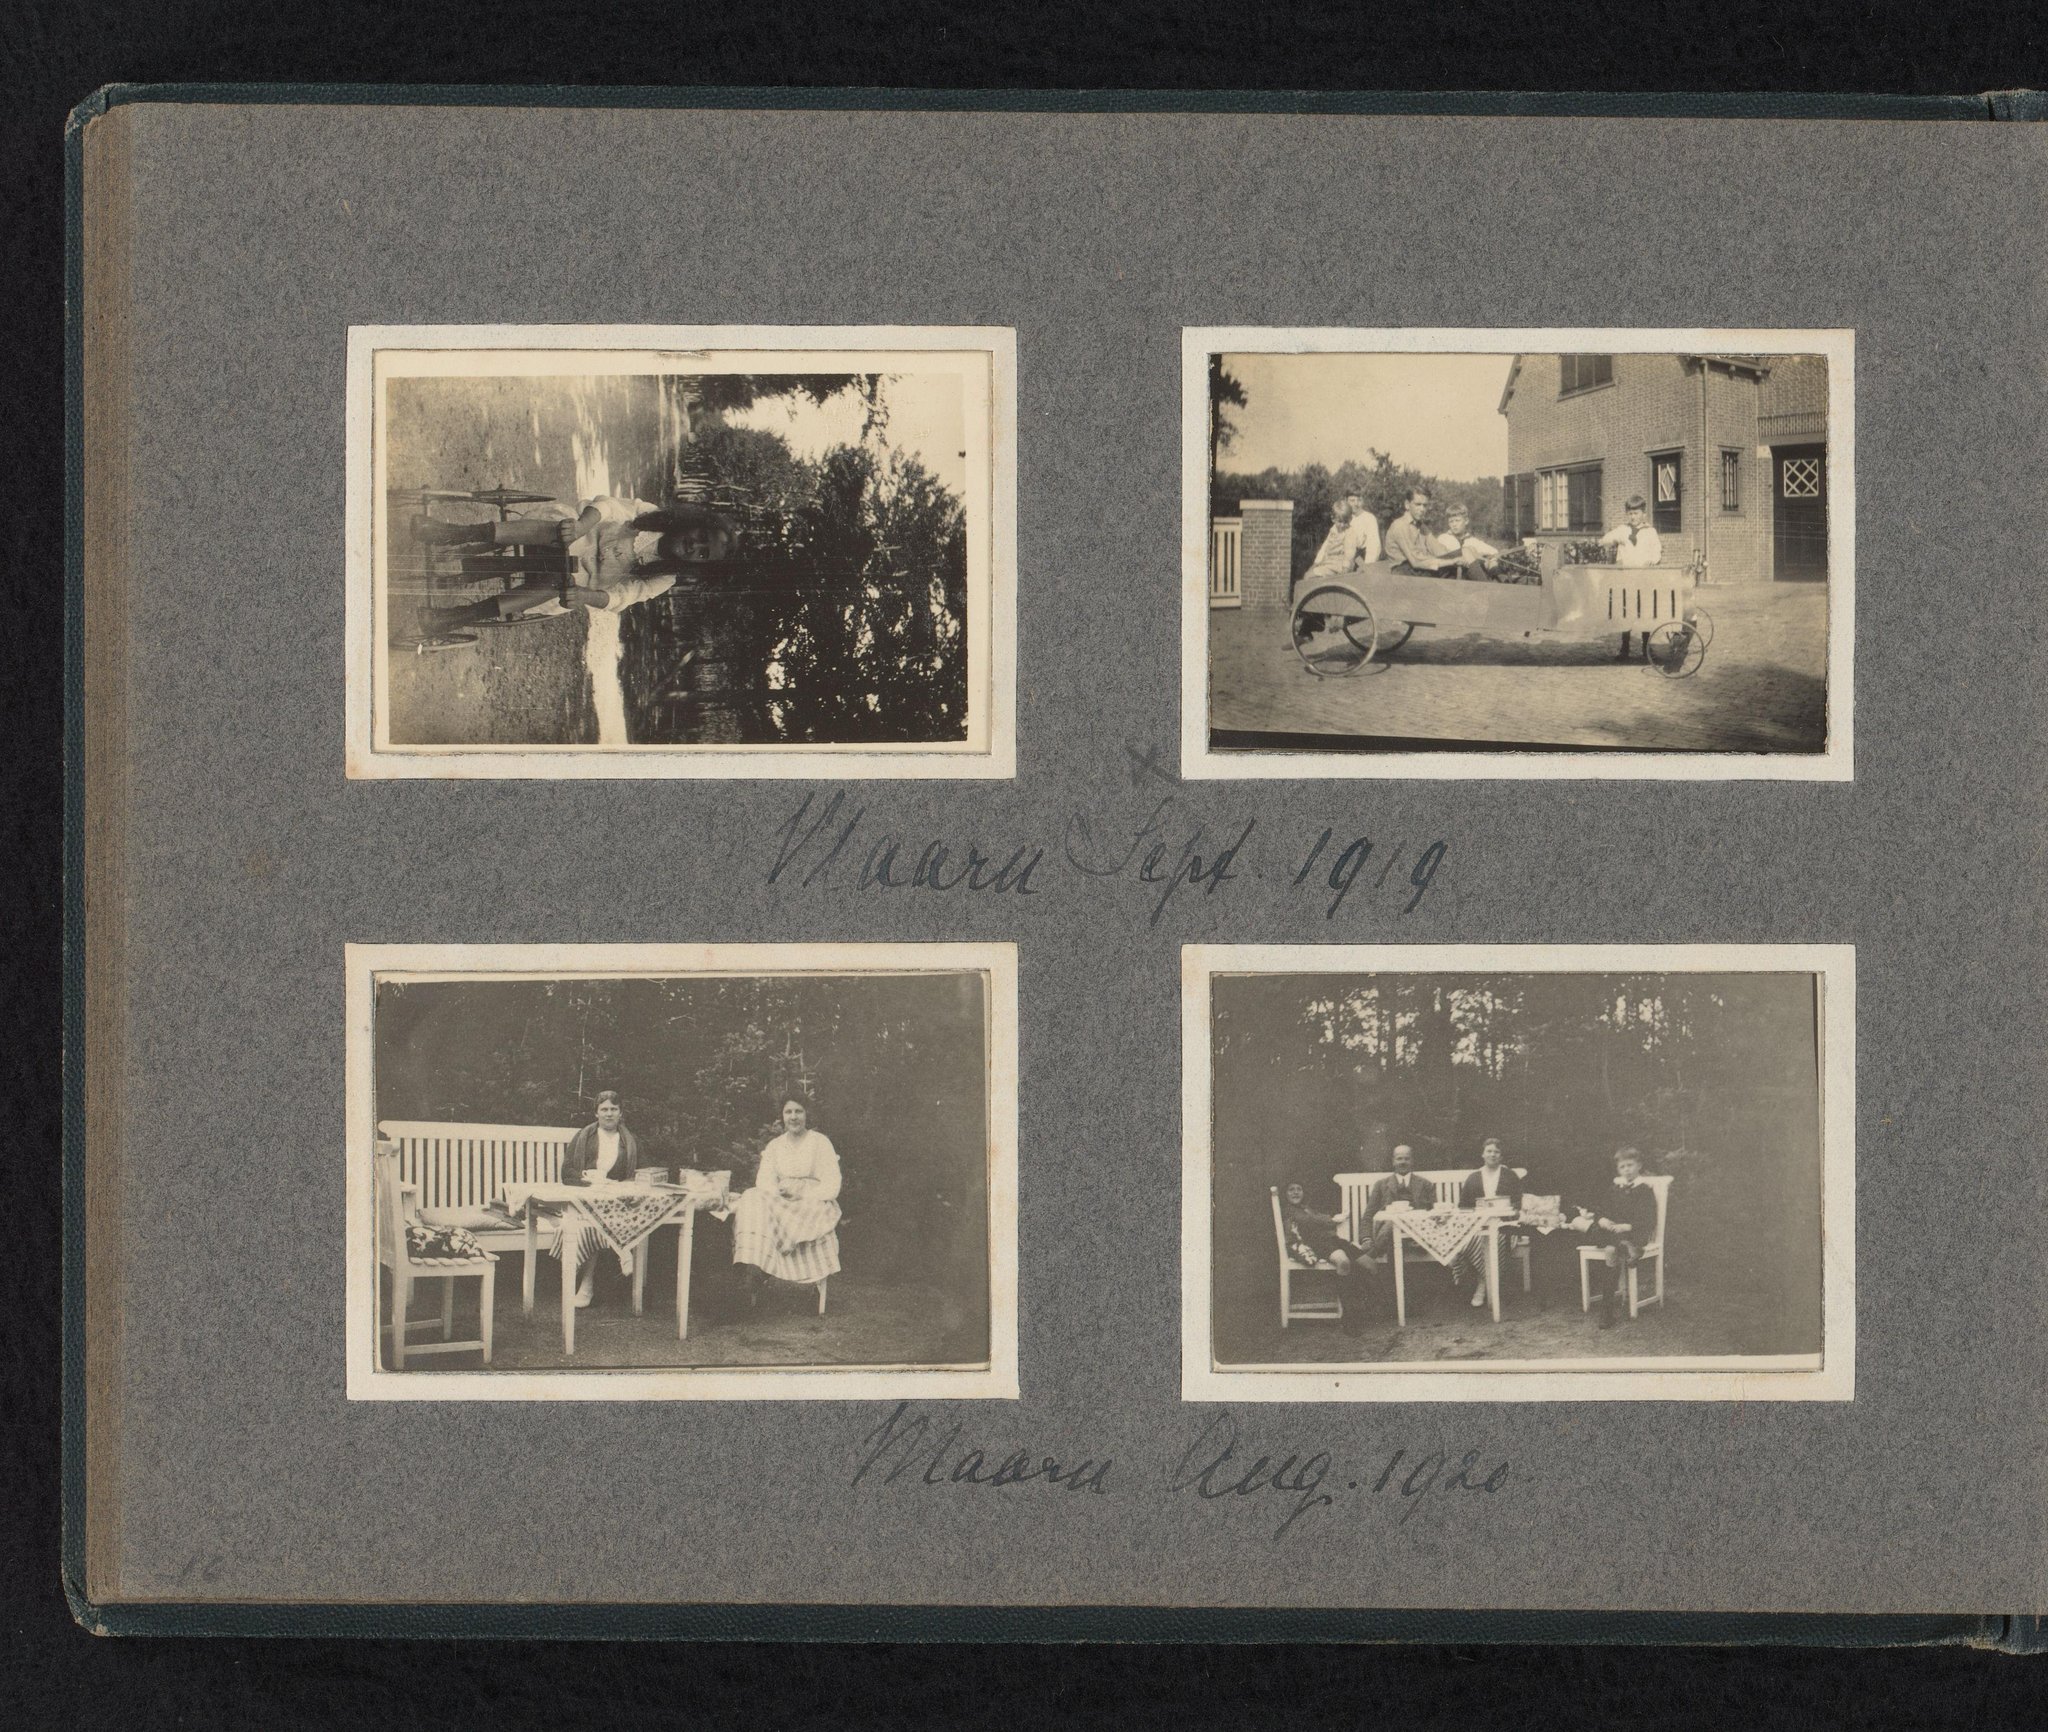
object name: photograph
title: Familie van den berg in Maarn, met Hendrik, Caroline, Carel en Frank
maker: hendrik herman van den berg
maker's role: amateurfotograaf, jurist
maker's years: 1875-1944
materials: paper, cardboard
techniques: gelatin silver print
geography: maarn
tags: hendrik herman van den berg, the hague, caroline louise van den berg-van den berg, amsterdam, carel frederik van den berg (cay), frank willem van den berg (1912-1998), family life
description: Deze foto's zijn onderdeel van een album.